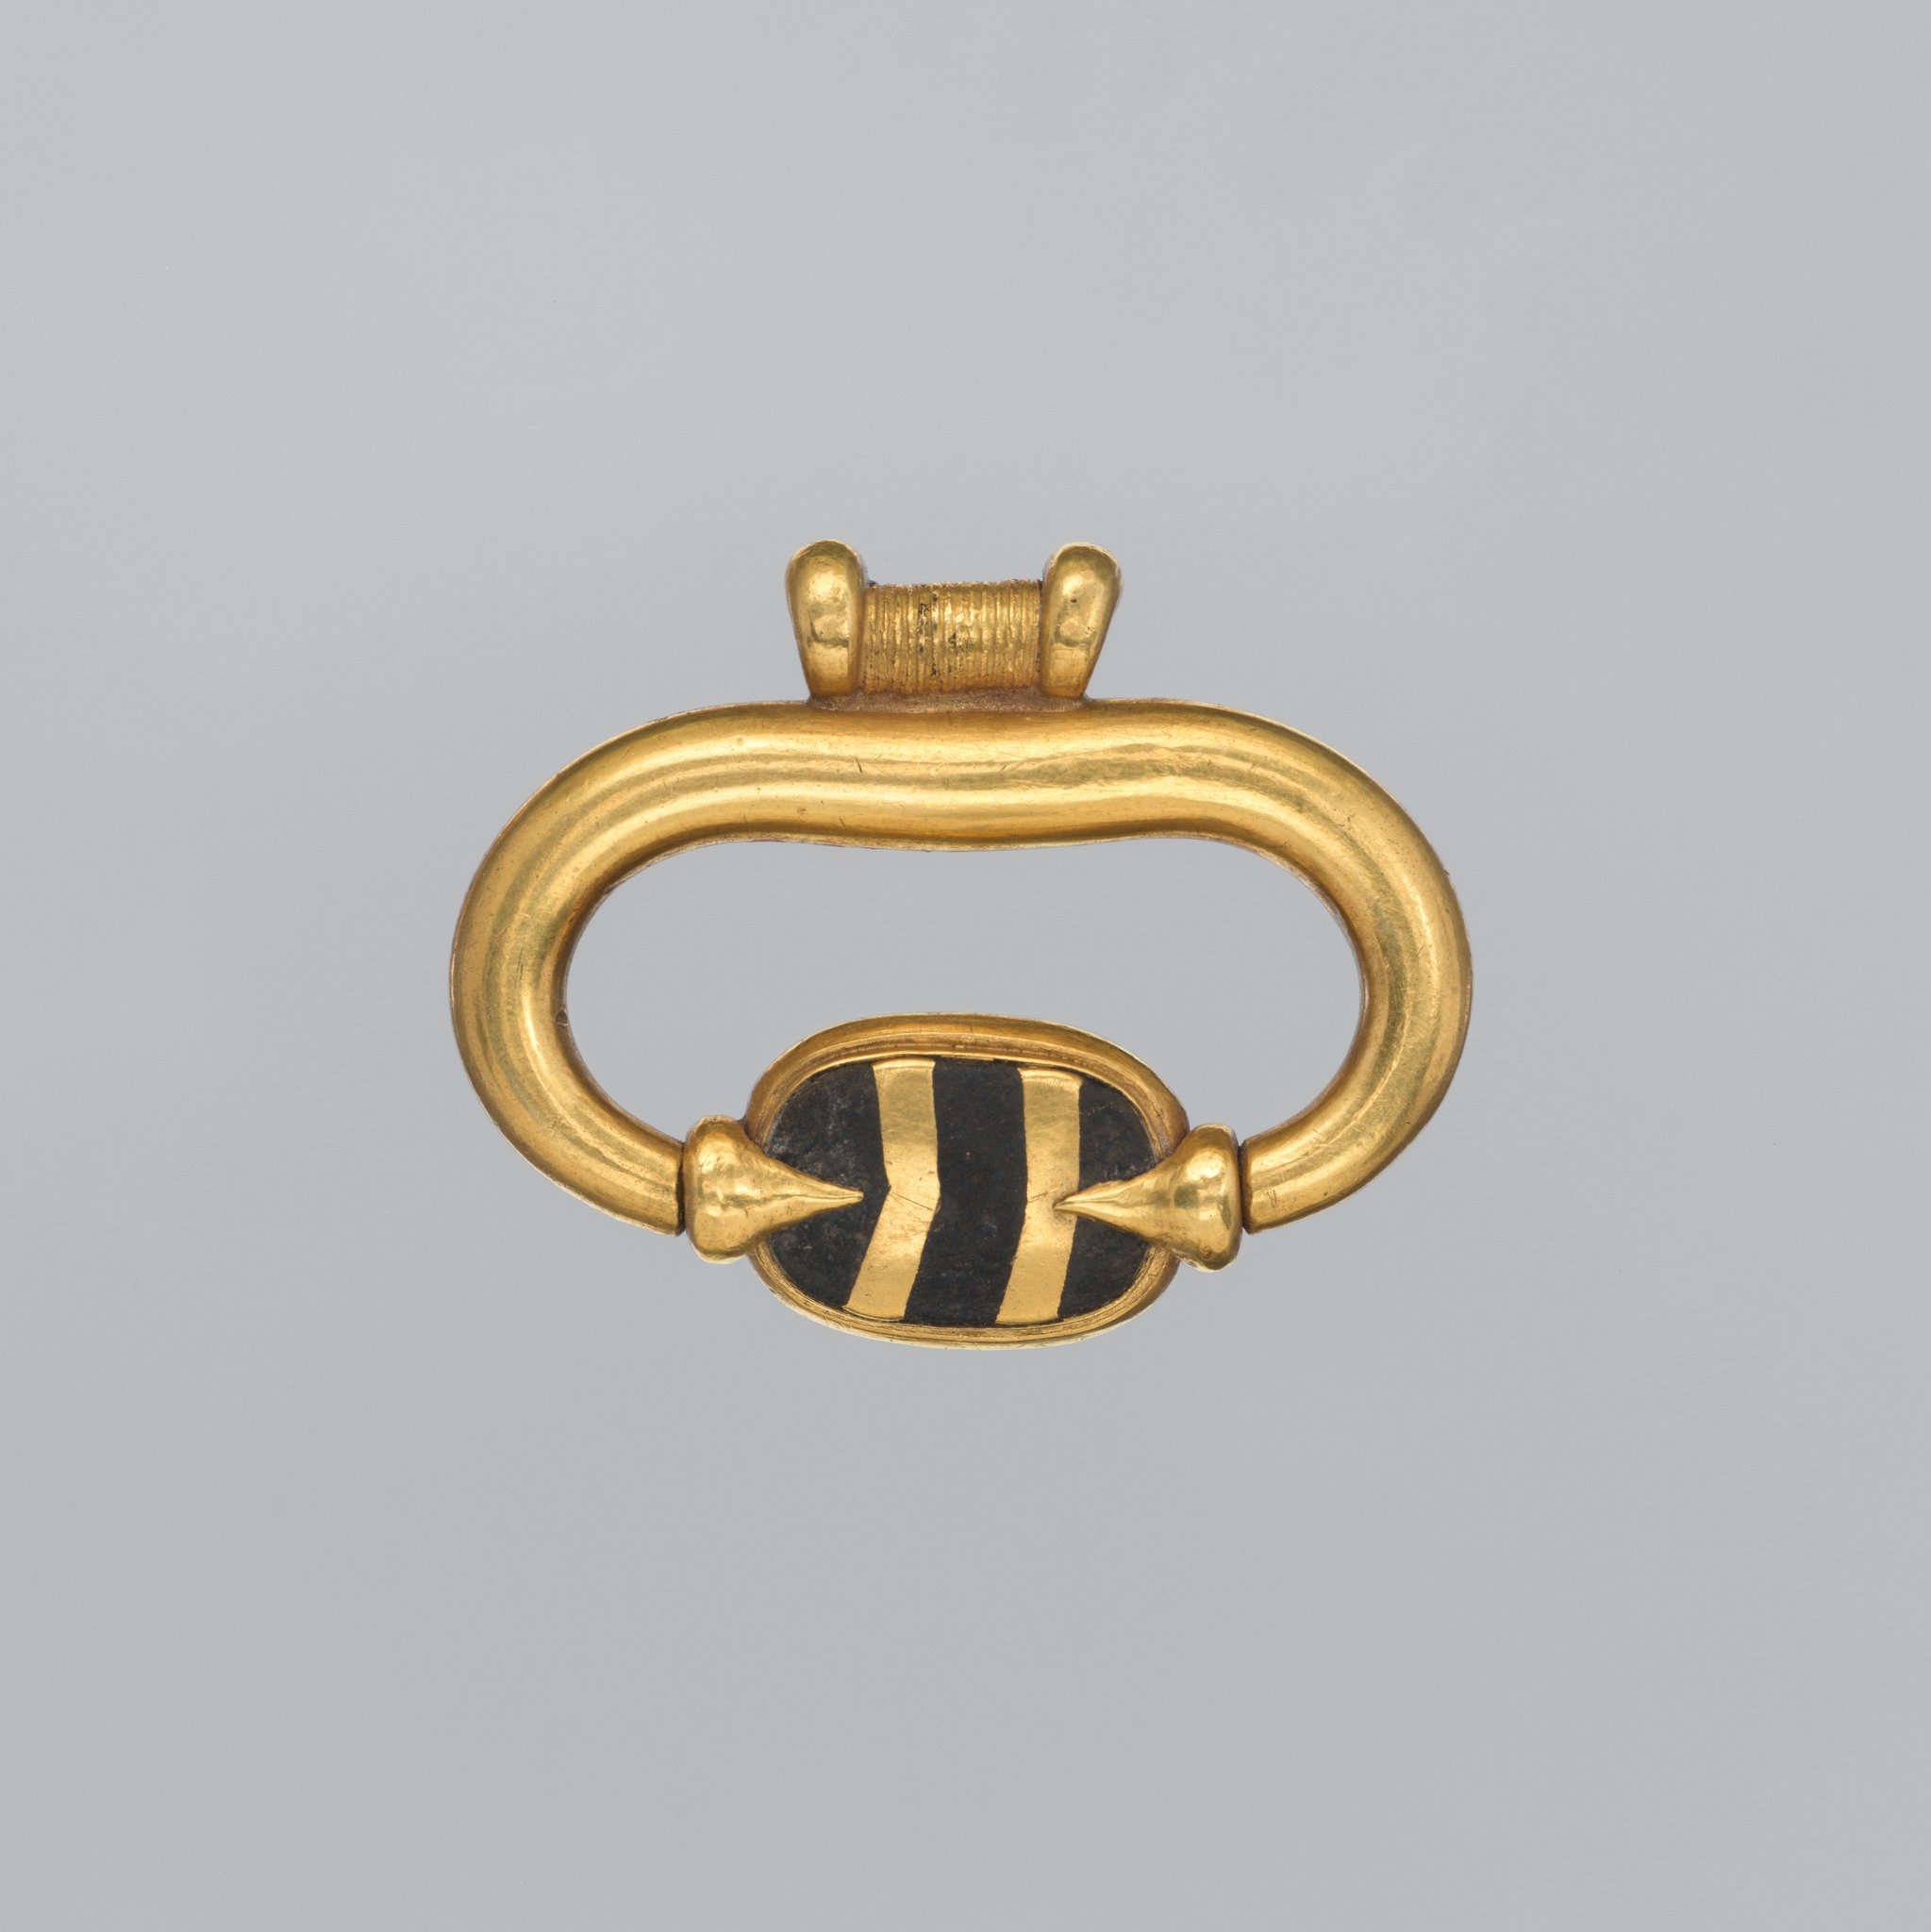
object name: ring with scaraboid pendant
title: Gold and lapis lazuli pendant ring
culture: cypro-phoenician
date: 600-468 BCE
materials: gold, lapis lazuli